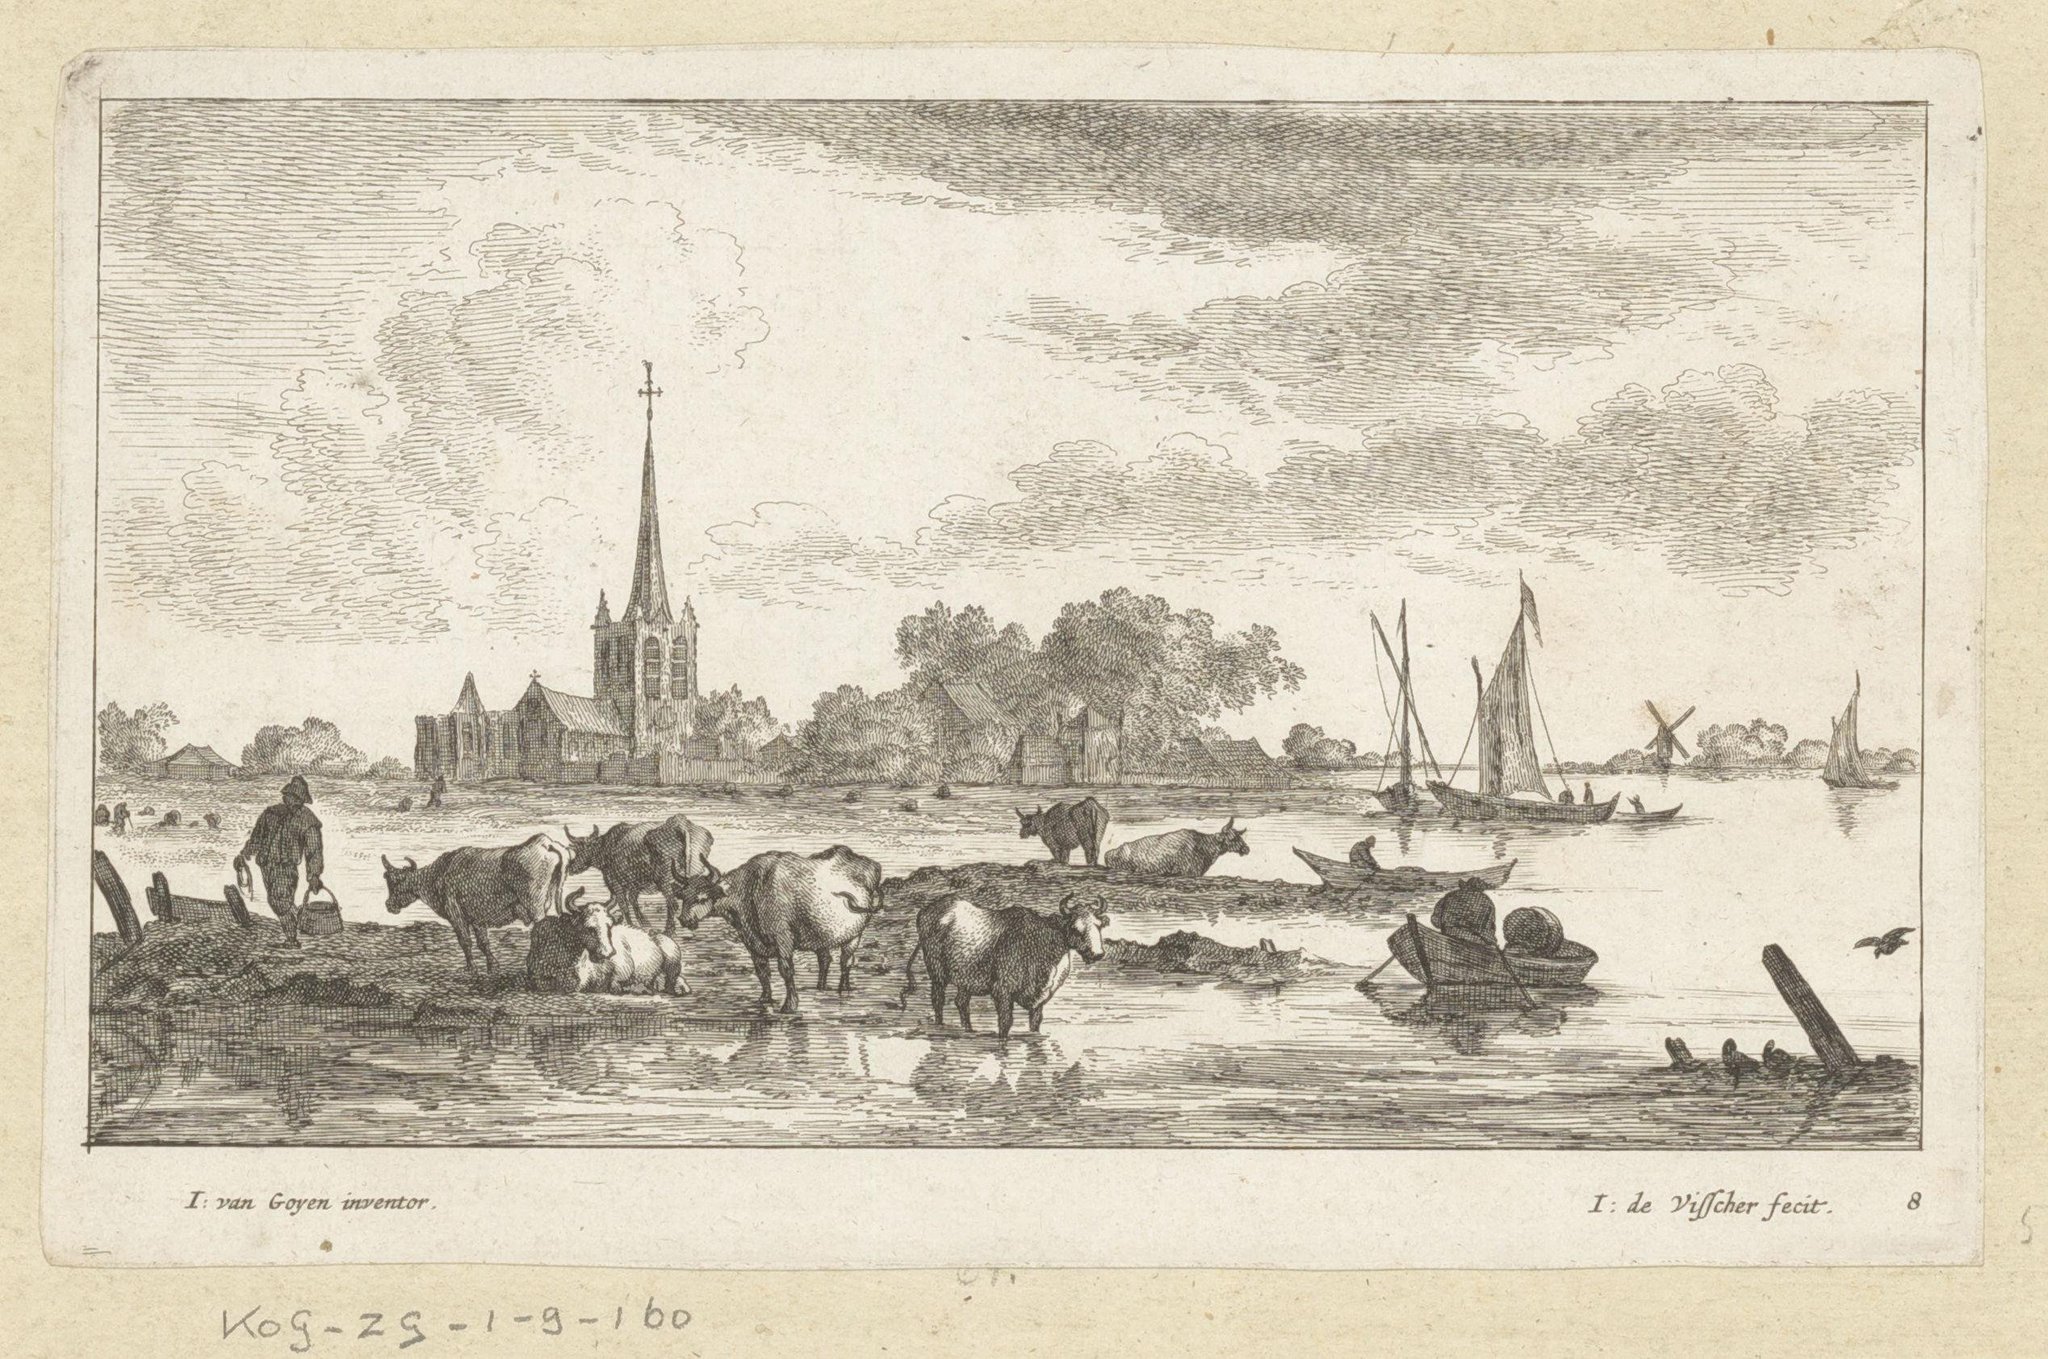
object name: print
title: Aangename regio's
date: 1682-1709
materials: paper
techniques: engraving, etching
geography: amsterdam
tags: cow, sailing-ship, sailing-boat, river, church (exterior), windmill in landscape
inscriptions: collector's mark: Lugt 1641, stamp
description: In de uiterwaarden doet een kudde koeien zich tegoed aan gras en water. Een boer met in zijn hand een emmer, loopt juist van de kudde vandaan. Op de rivier zeilschepen en roeiboten. Aan de overzijde van het water een dorp met een kerk en rechts een molen. Rechtsonder genummerd: 8. Onderwerpsrubrieken binnen de Atlas Zeden en Gewoonten: Handel, nijverheid en verkeer, Buitenleven.